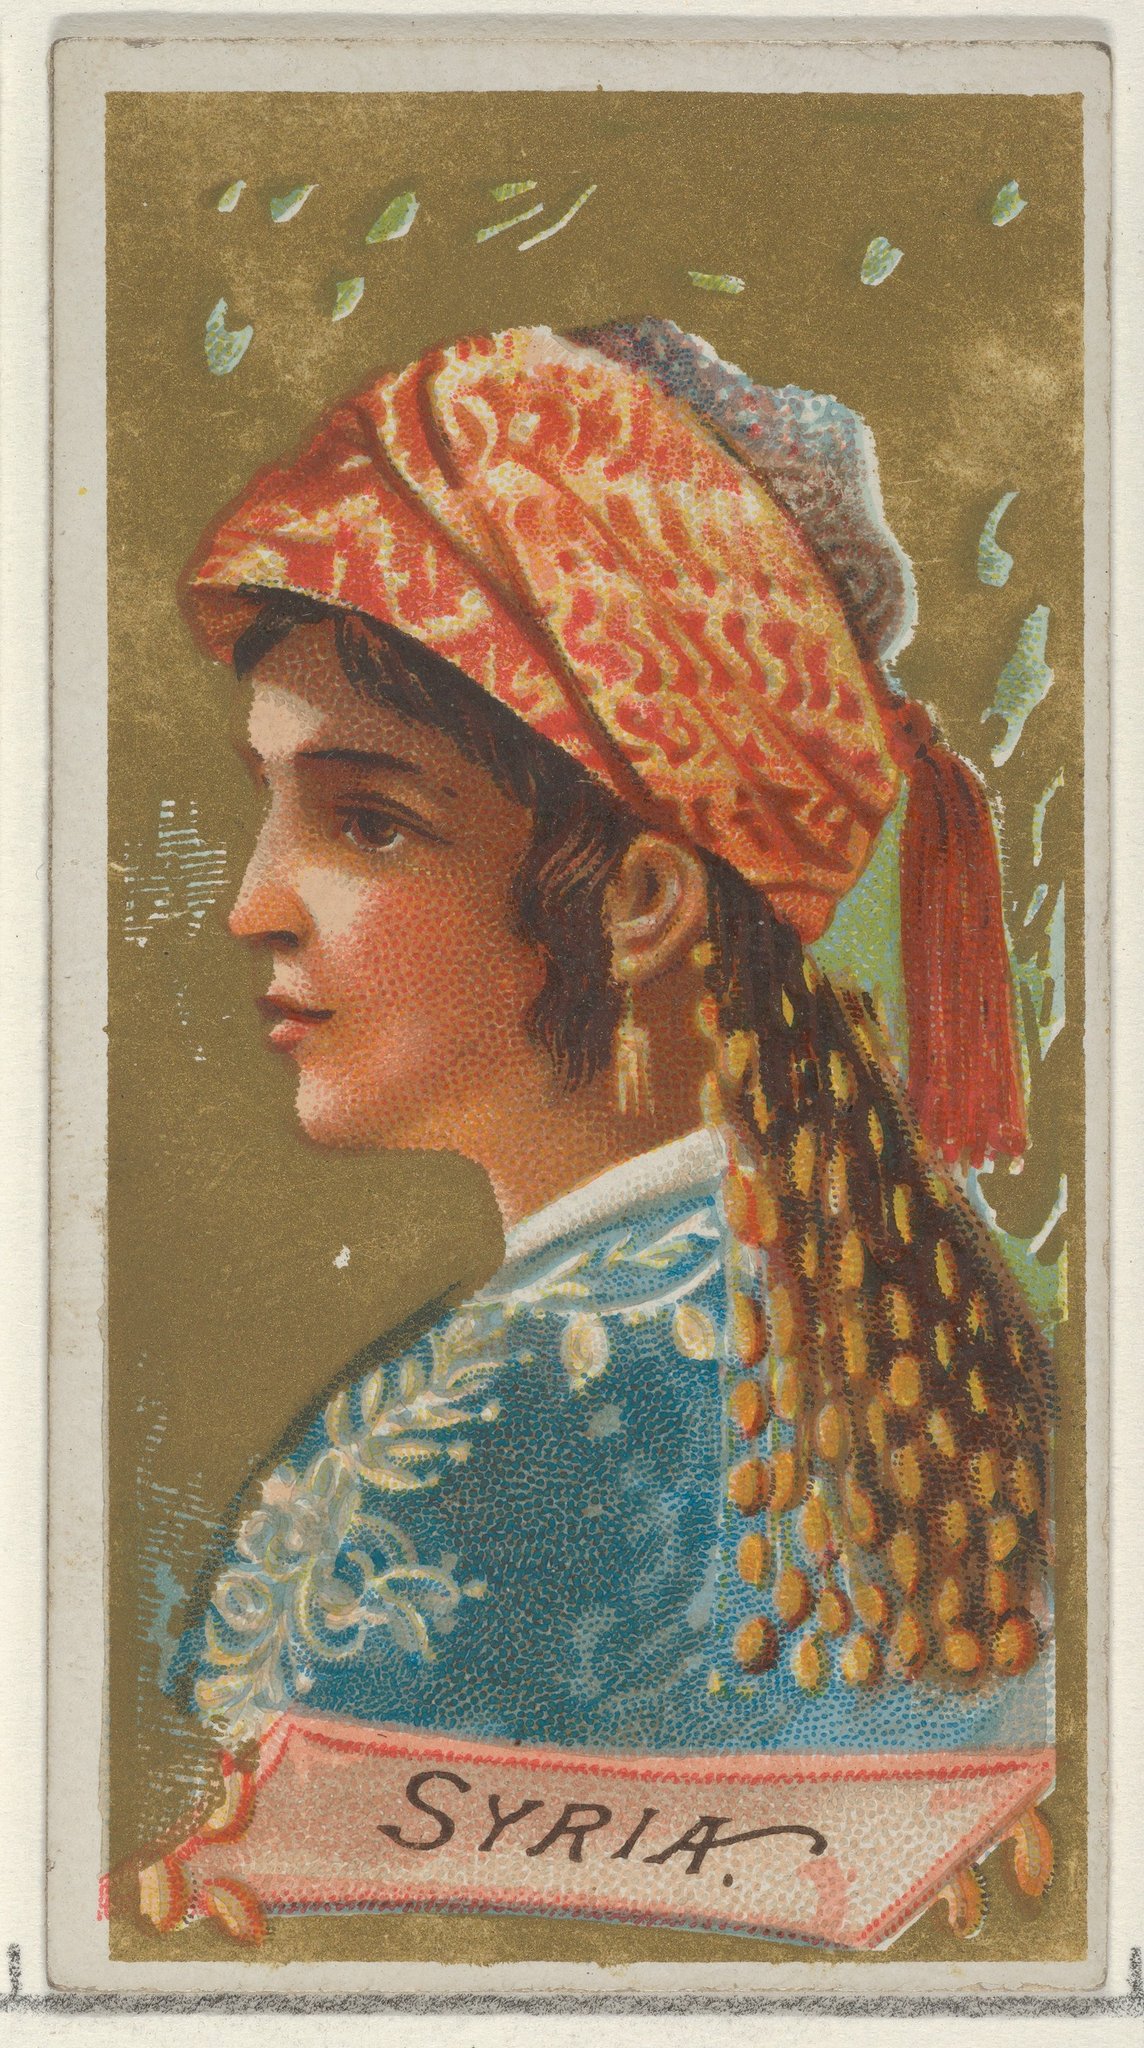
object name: print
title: Syria, from the Types of All Nations series (N24) for Allen & Ginter Cigarettes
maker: allen & ginter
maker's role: publisher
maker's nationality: american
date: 1889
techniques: color lithograph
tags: profiles,women